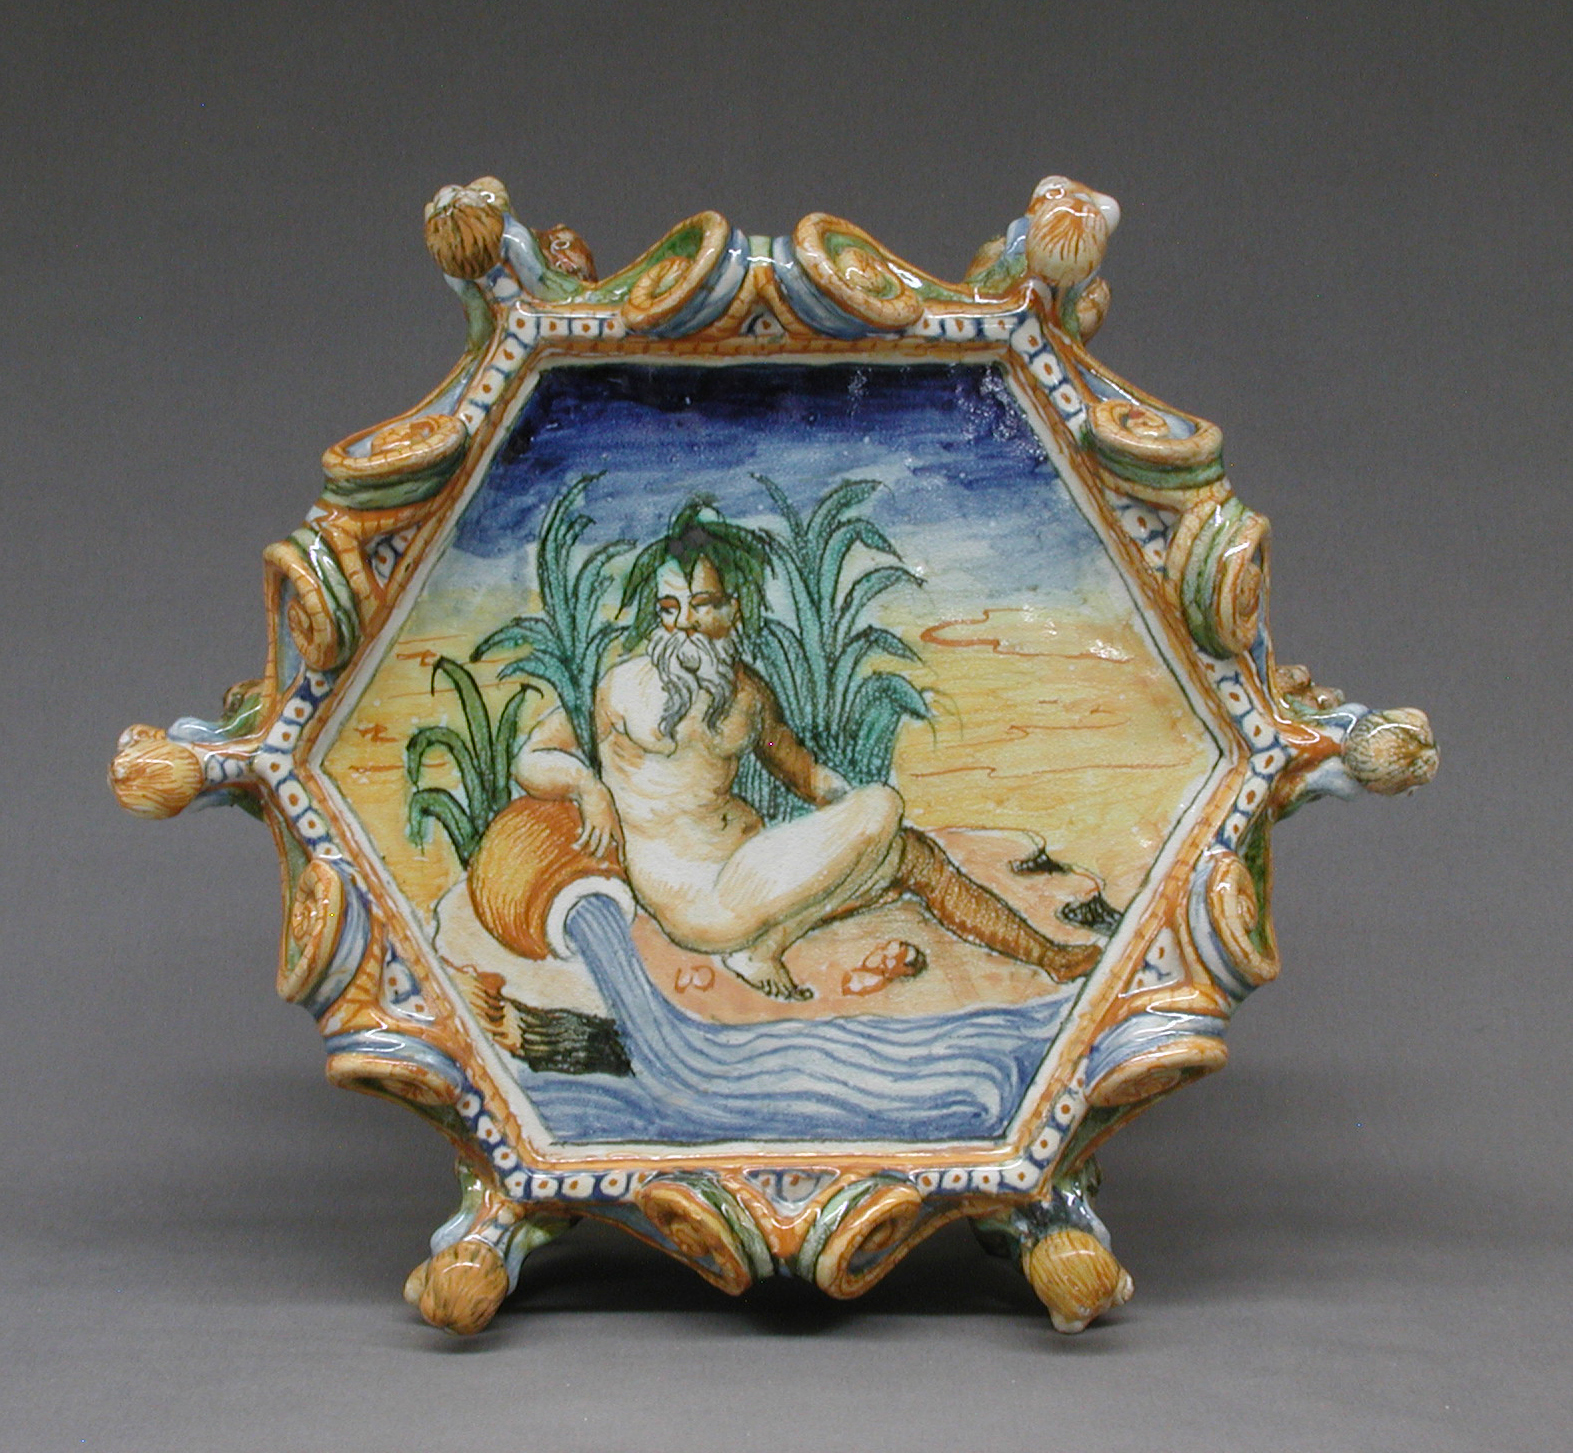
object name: writing case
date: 1575-1600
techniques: maiolica, glazing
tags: male nudes